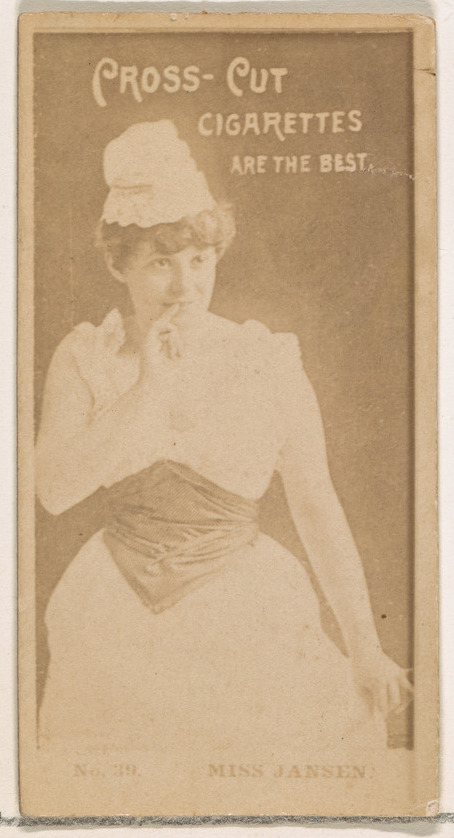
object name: print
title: Card Number 39, Marie Jansen, from the Actors and Actresses series (N145-2) issued by Duke Sons & Co. to promote Cross Cut Cigarettes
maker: w. duke, sons & co.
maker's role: publisher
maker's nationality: american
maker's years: 1870-1920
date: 1880-1889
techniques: albumen silver print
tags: portraits,women,actresses